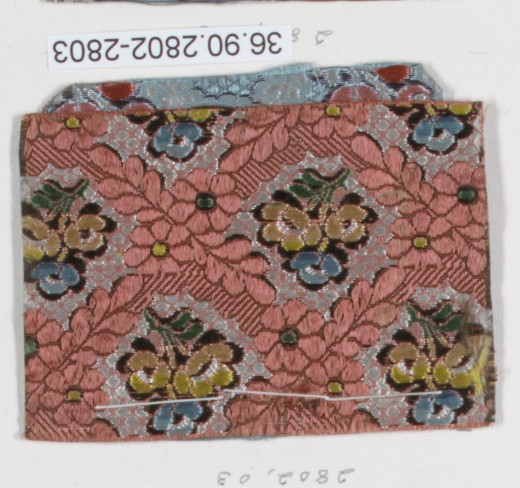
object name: piece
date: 1801-1900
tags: flowers,leaves